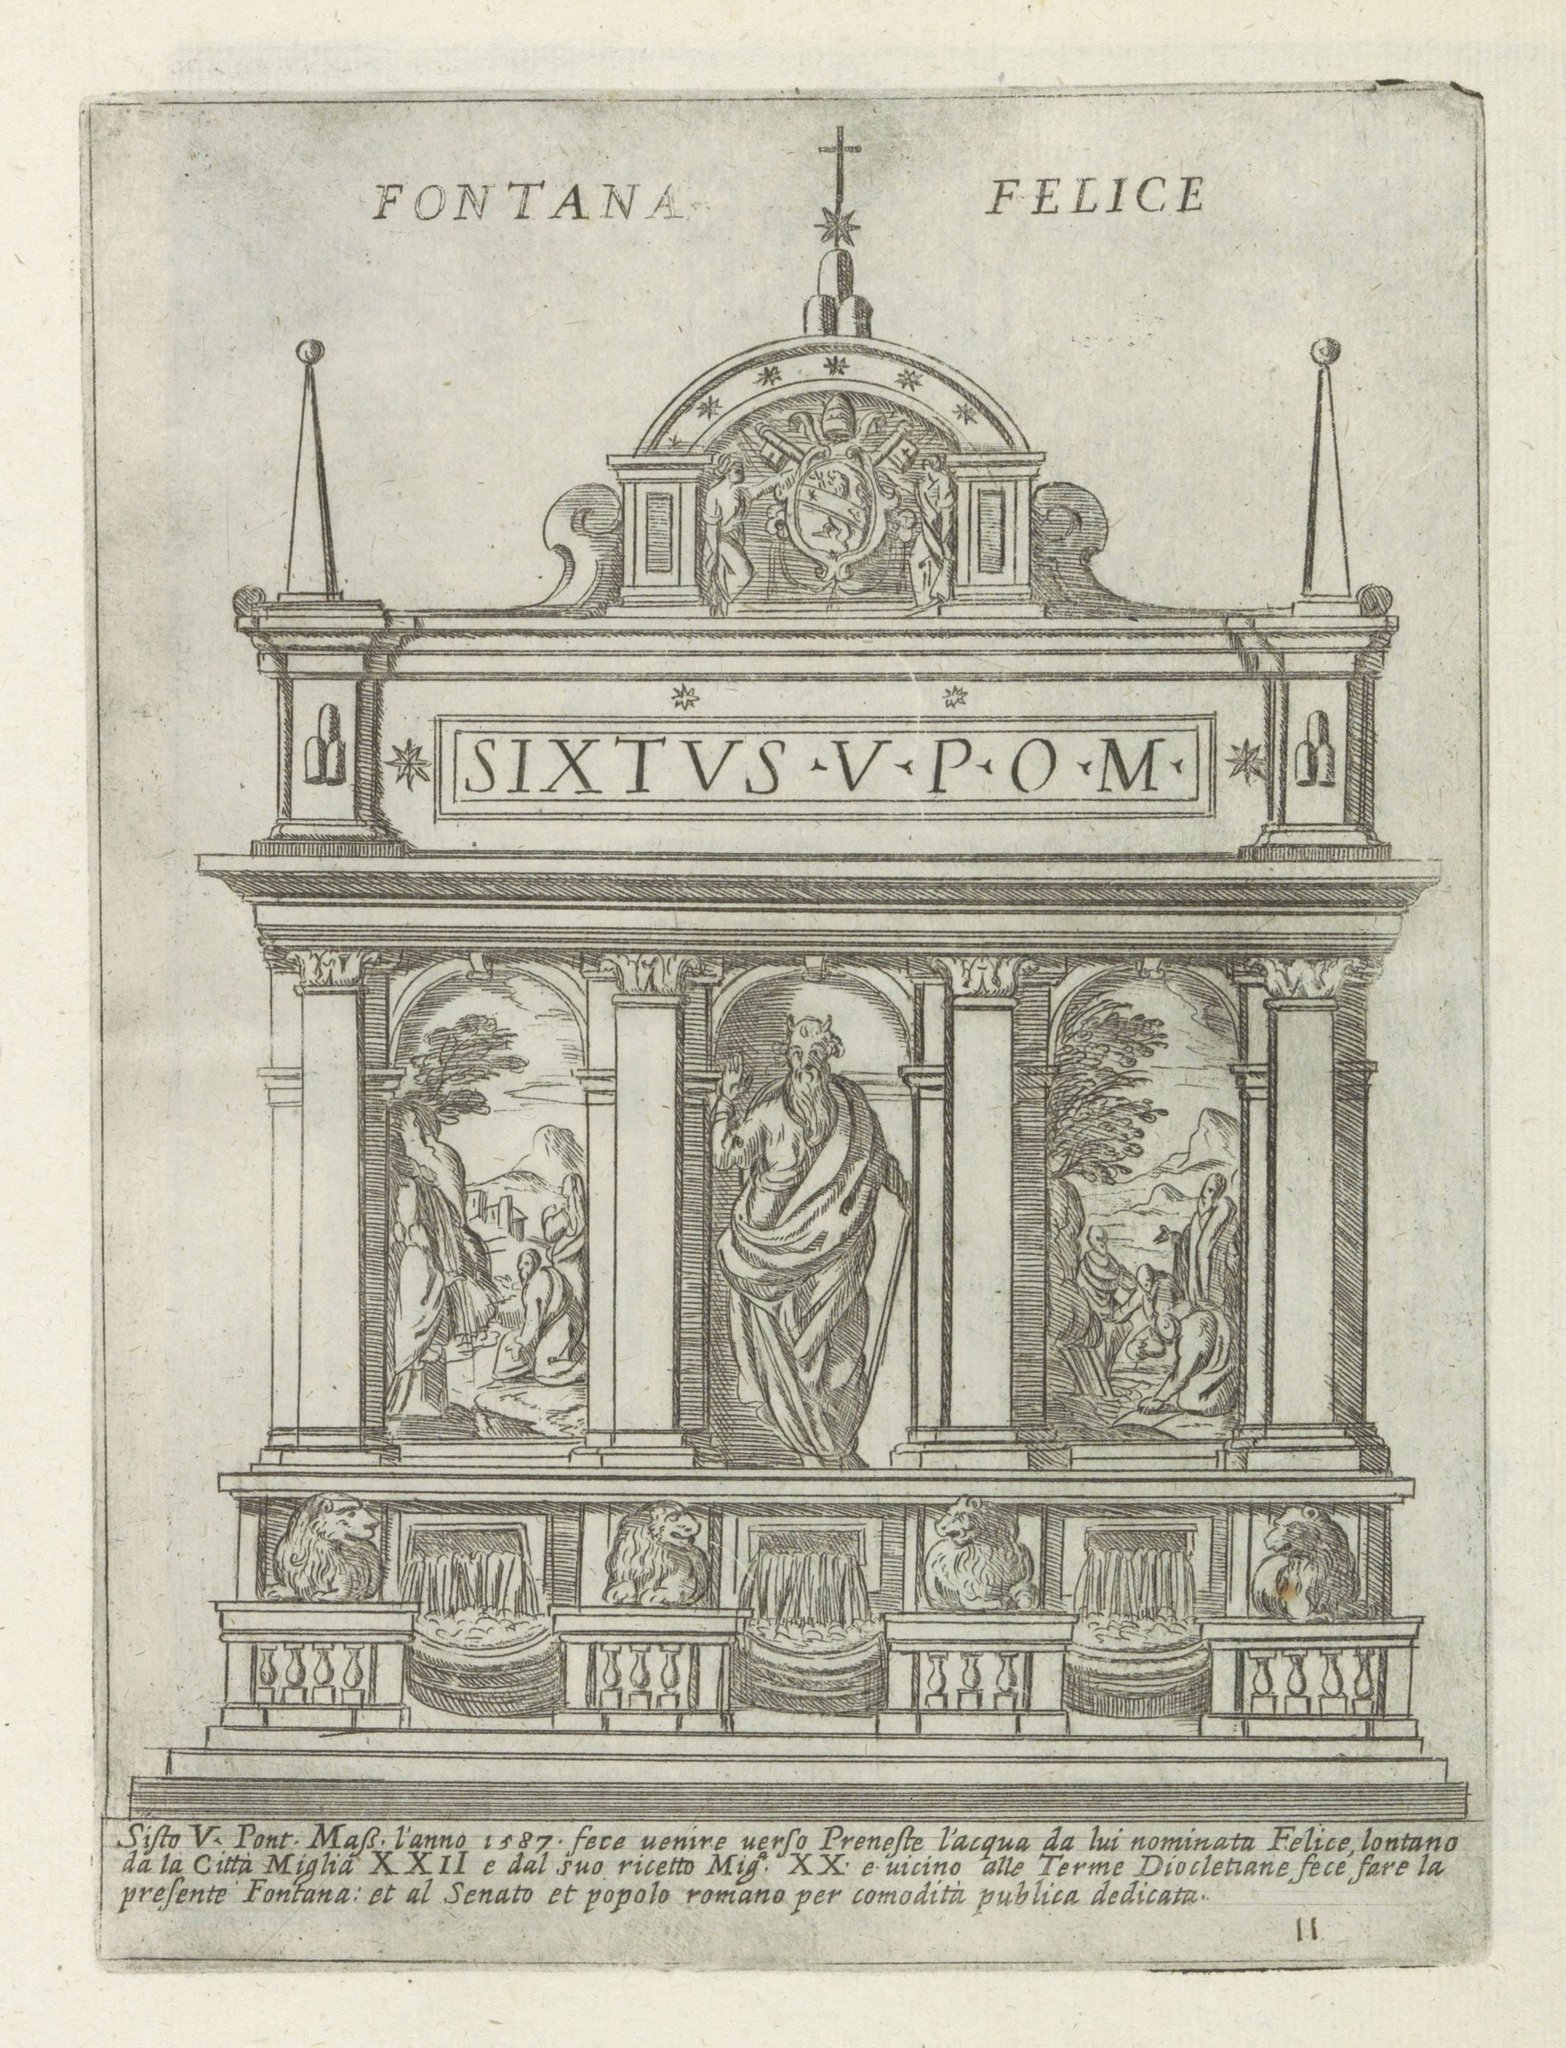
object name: album leaf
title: Fontana Felice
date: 1576-1618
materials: paper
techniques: etching, intaglio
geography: rome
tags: ornamental fountain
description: Tekst in het Italiaans onder de voorstelling. De prent maakt deel uit van een album.